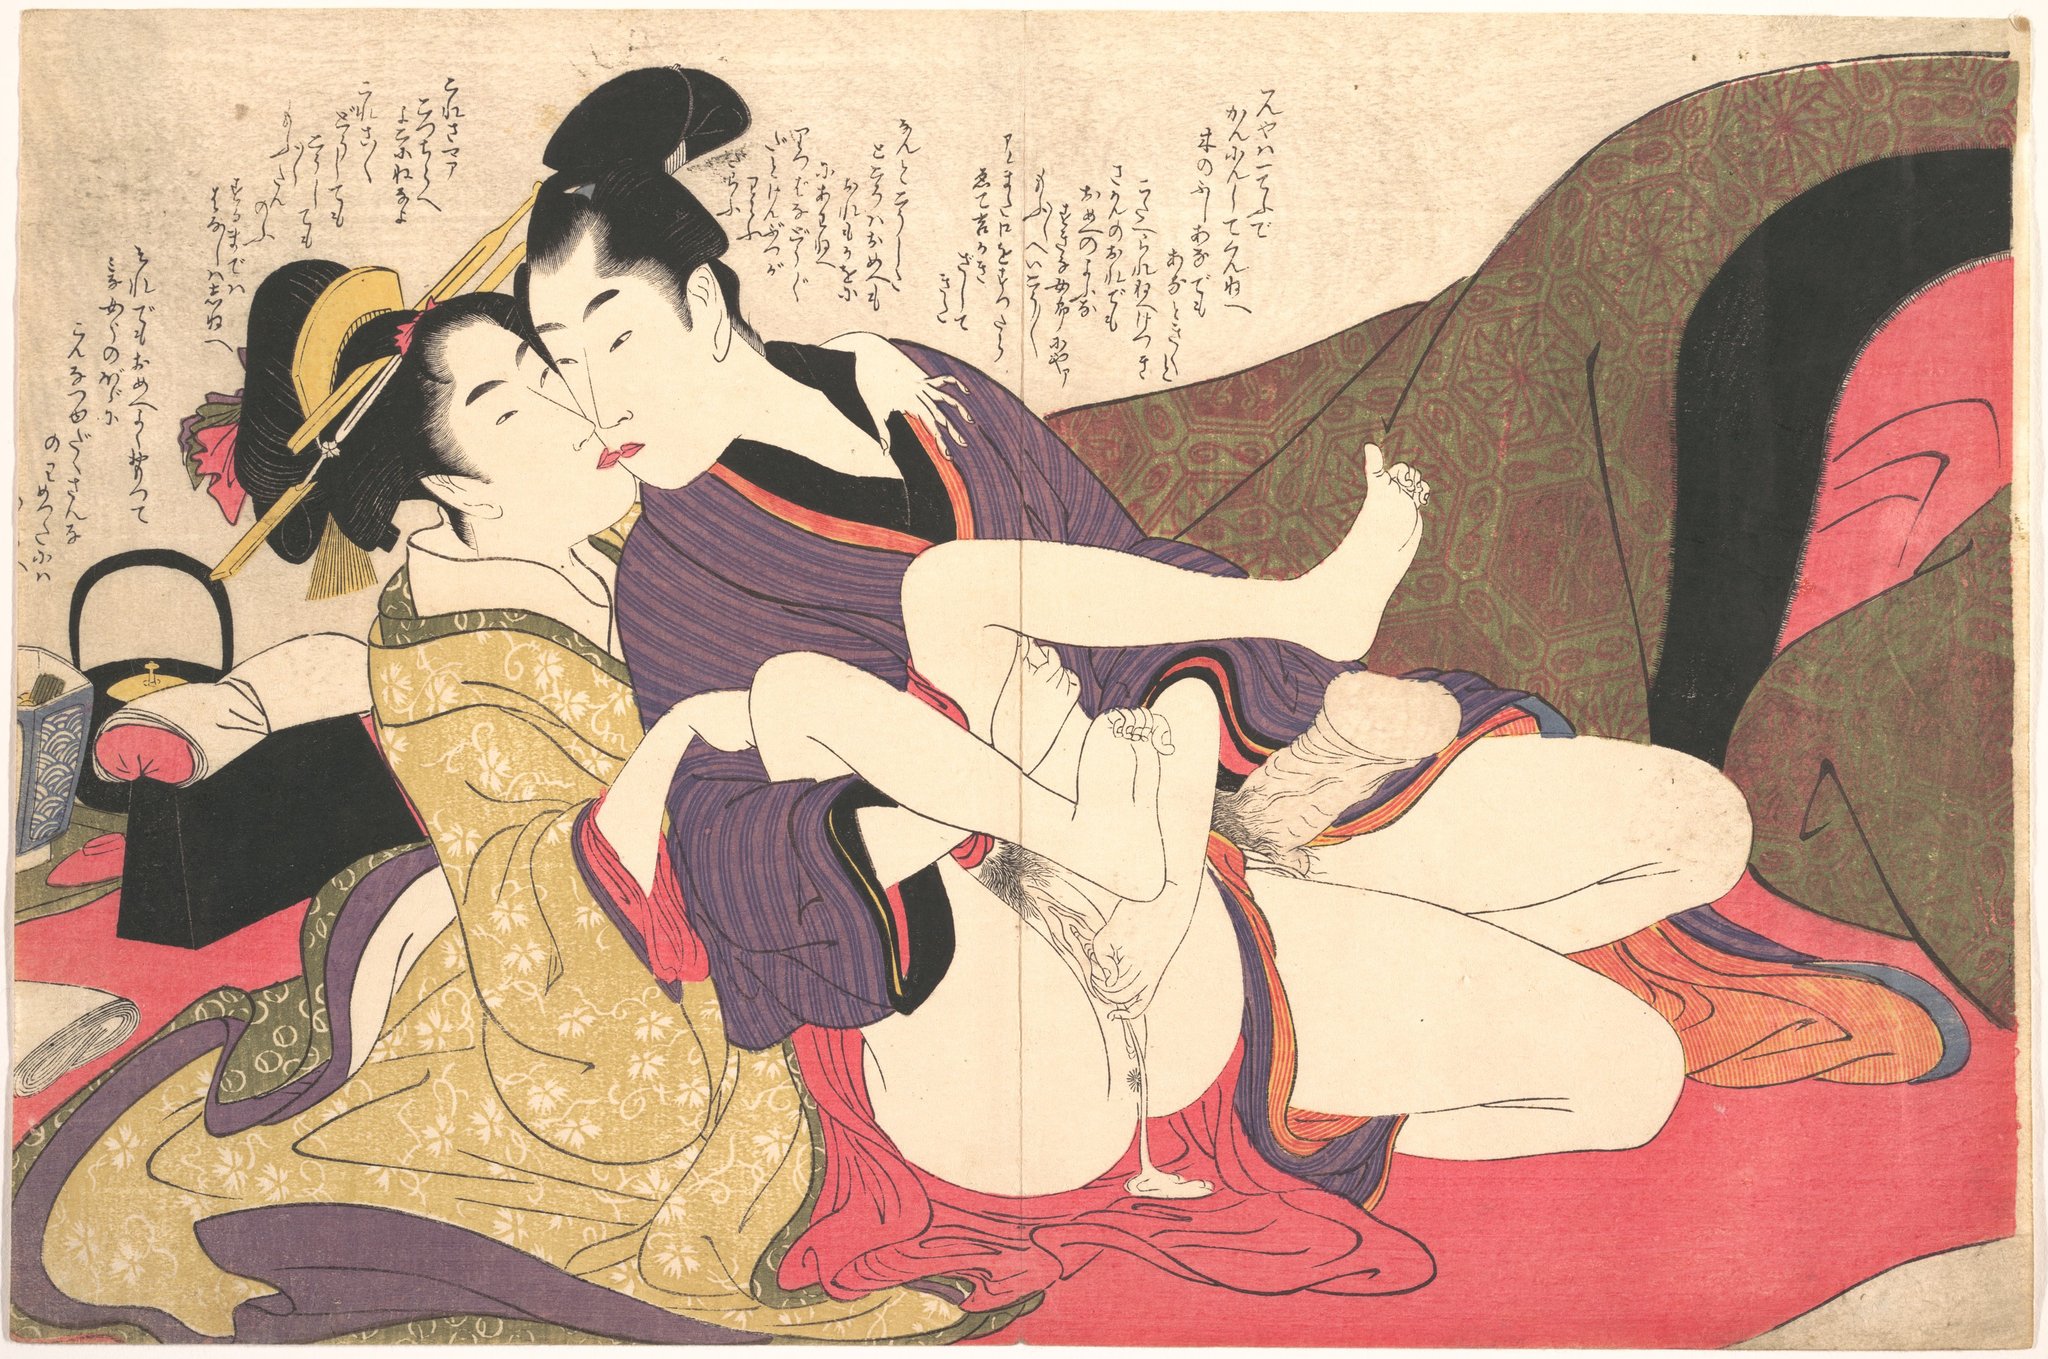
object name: print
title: Erotic Print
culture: japanese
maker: kitagawa utamaro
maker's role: artist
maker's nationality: japanese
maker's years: 1754-1806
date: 1753-1806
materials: ink, paper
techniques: woodblock print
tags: male nudes,female nudes